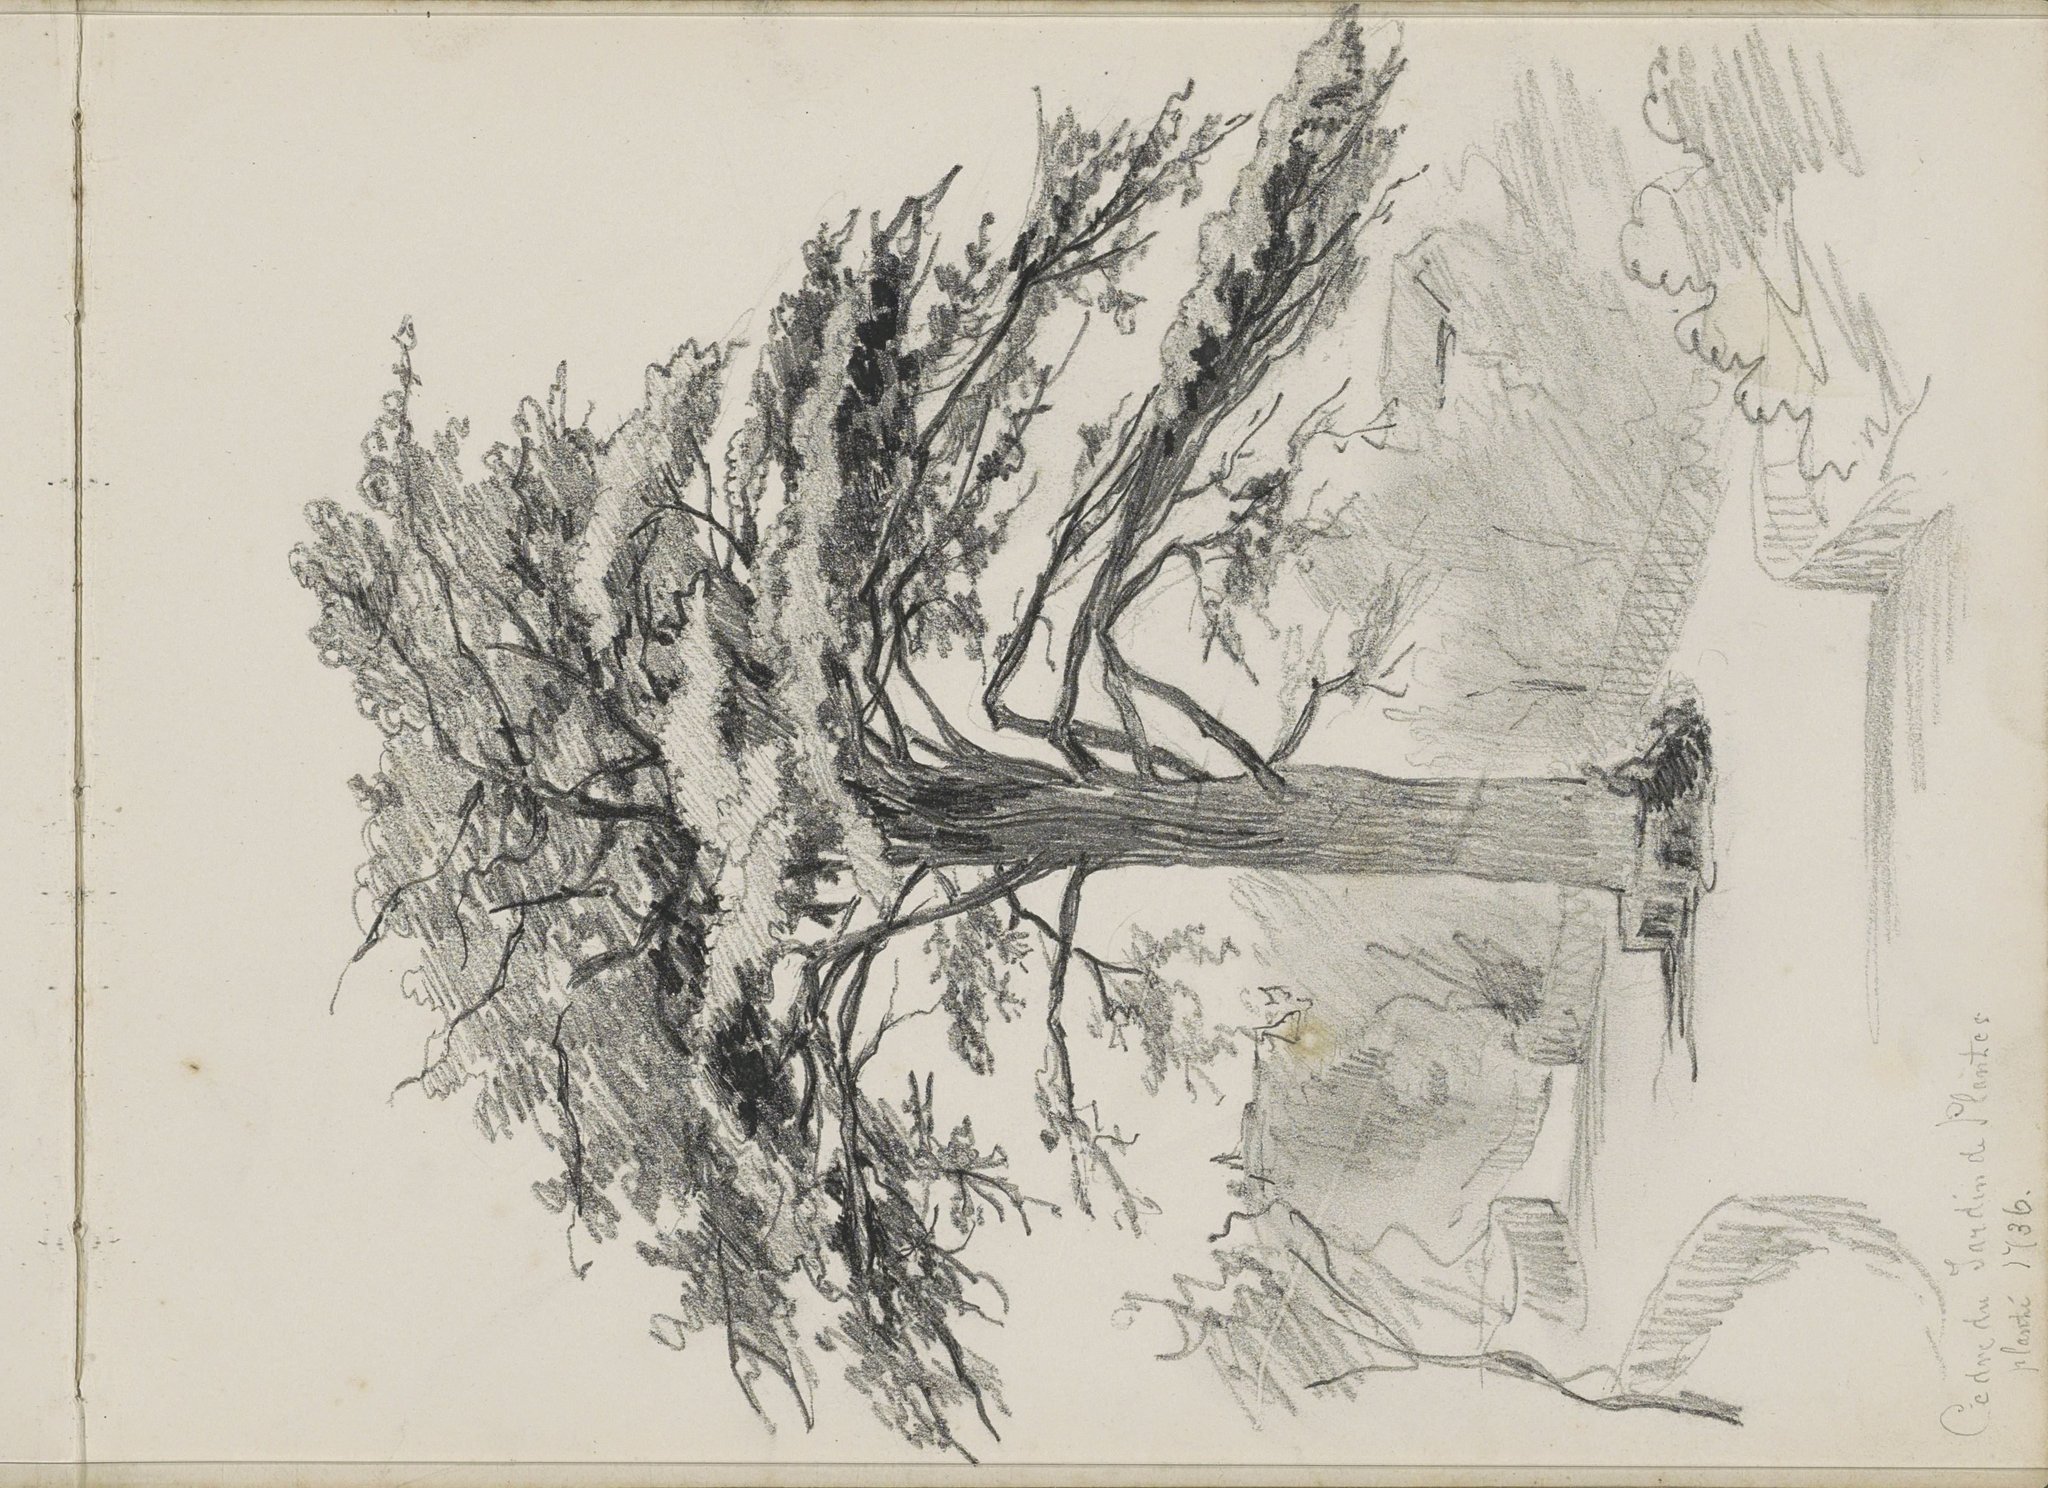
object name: sketchbook leaf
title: Ceder uit 1736 in de Jardin des Plantes te Parijs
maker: gerrit postma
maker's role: draughtsman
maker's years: 1819-1894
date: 1858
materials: paper, pencil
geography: paris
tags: botanic garden, 'hortus botanicus', trees: cedar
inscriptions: annotation: ‘Cedre du Jardin de Plantes/ planté 1736.’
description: Blad 13 recto uit een schetsboek met 52 bladen.